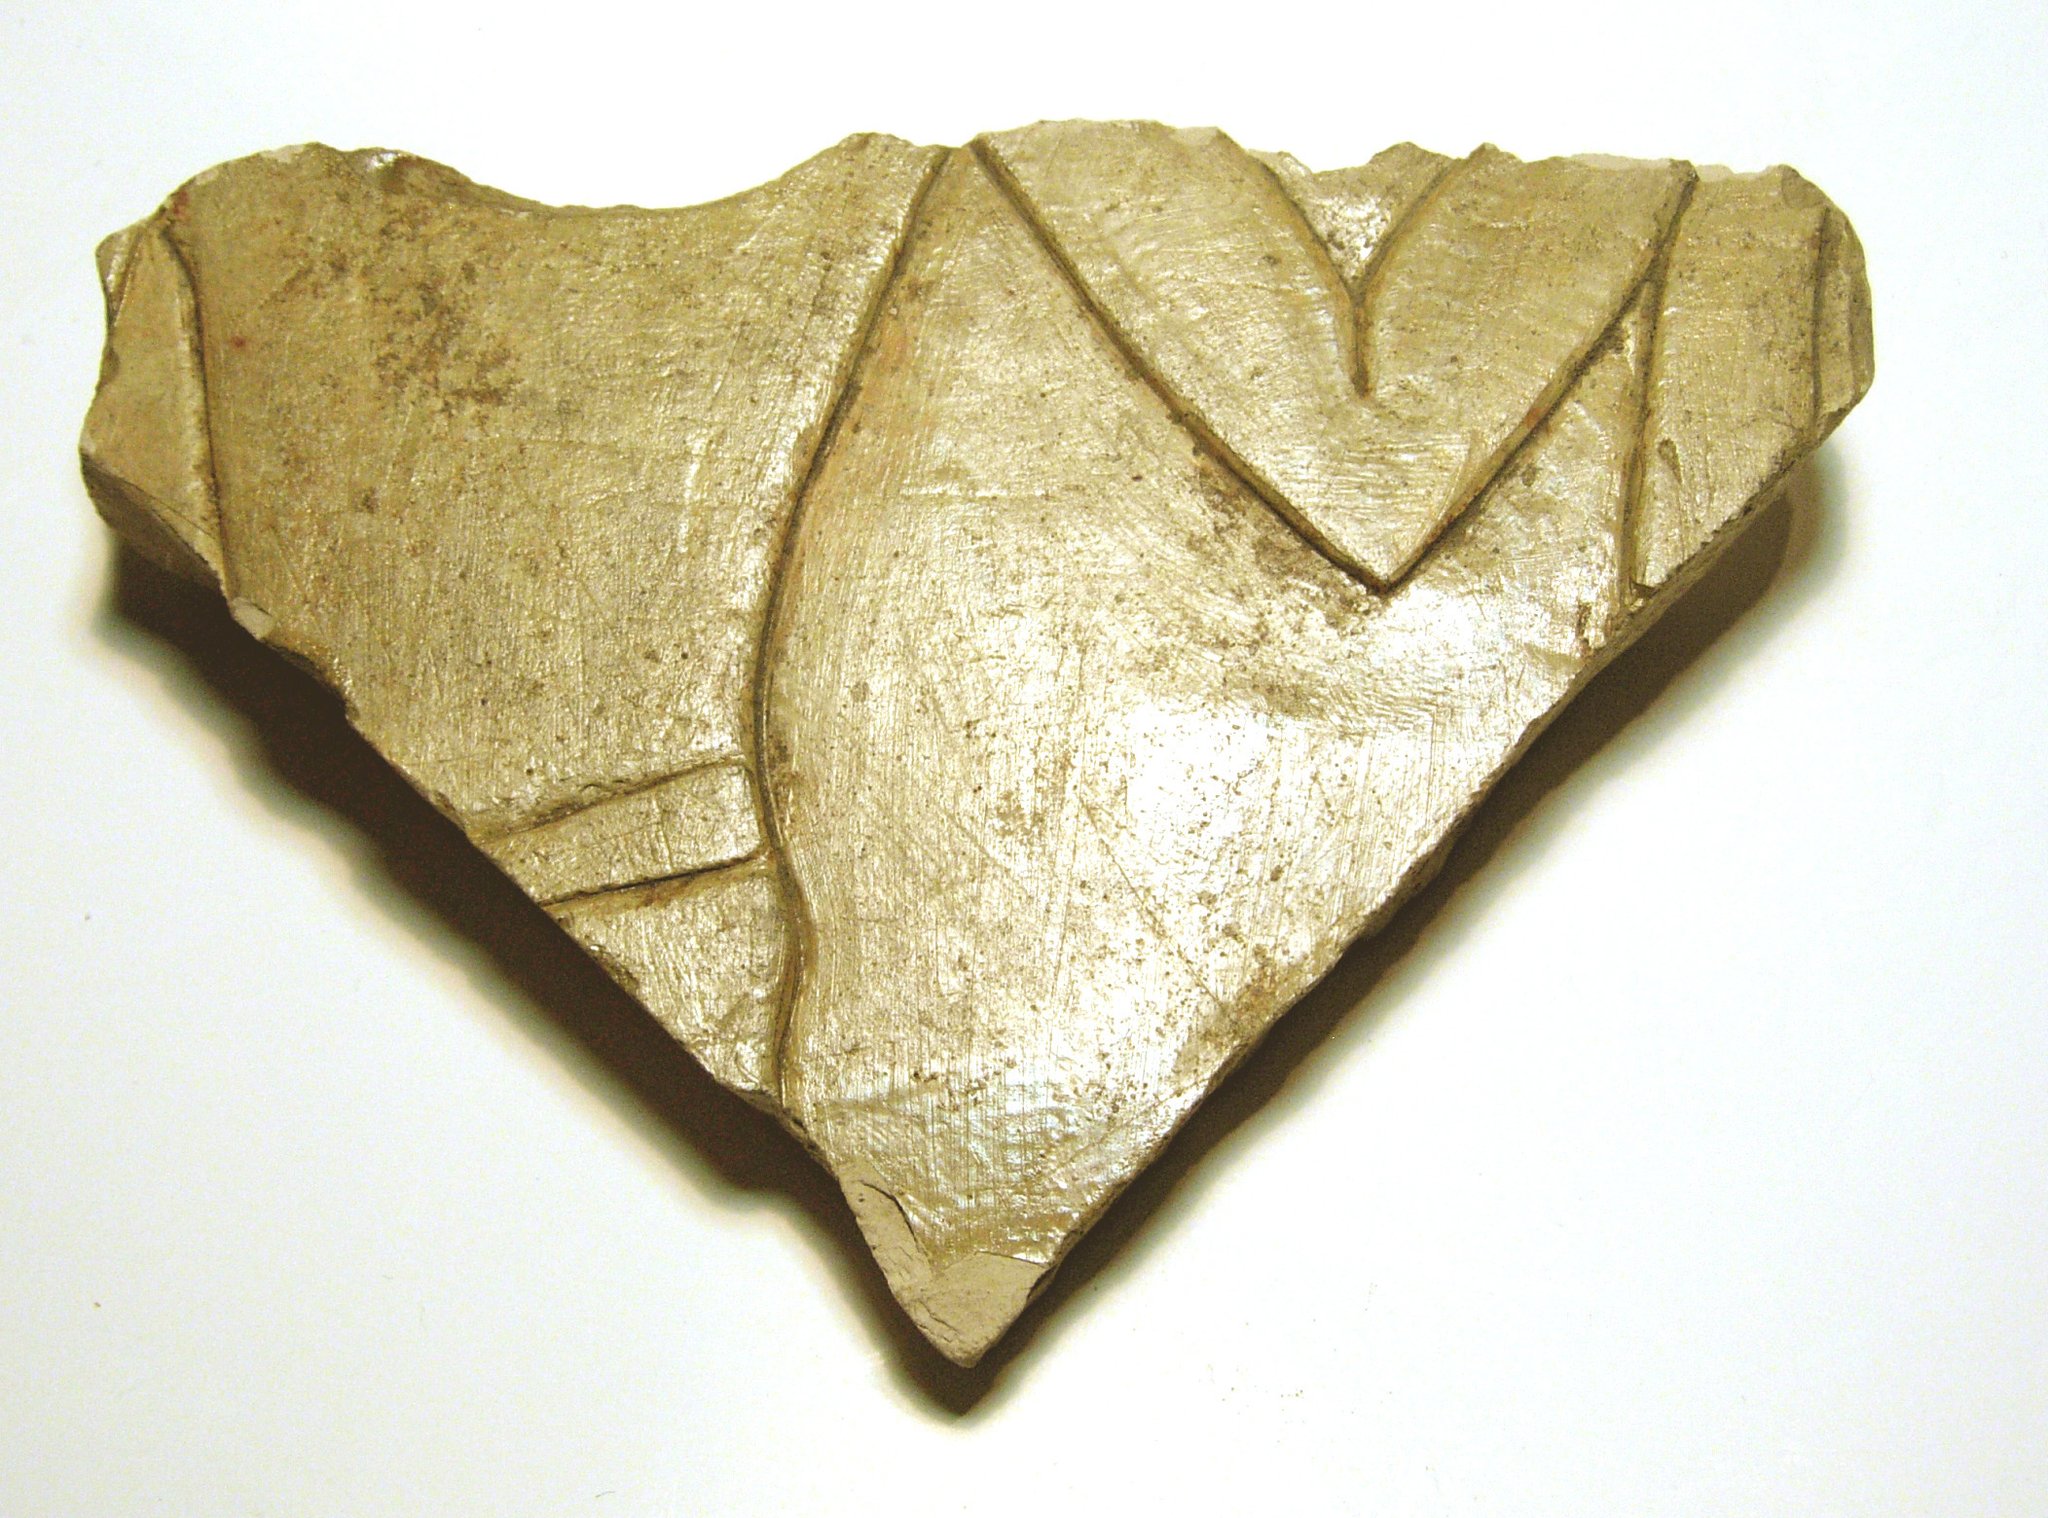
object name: relief, tomb of nespekashuty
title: Raised relief fragment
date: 664-610 BCE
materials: limestone, varnish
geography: egypt